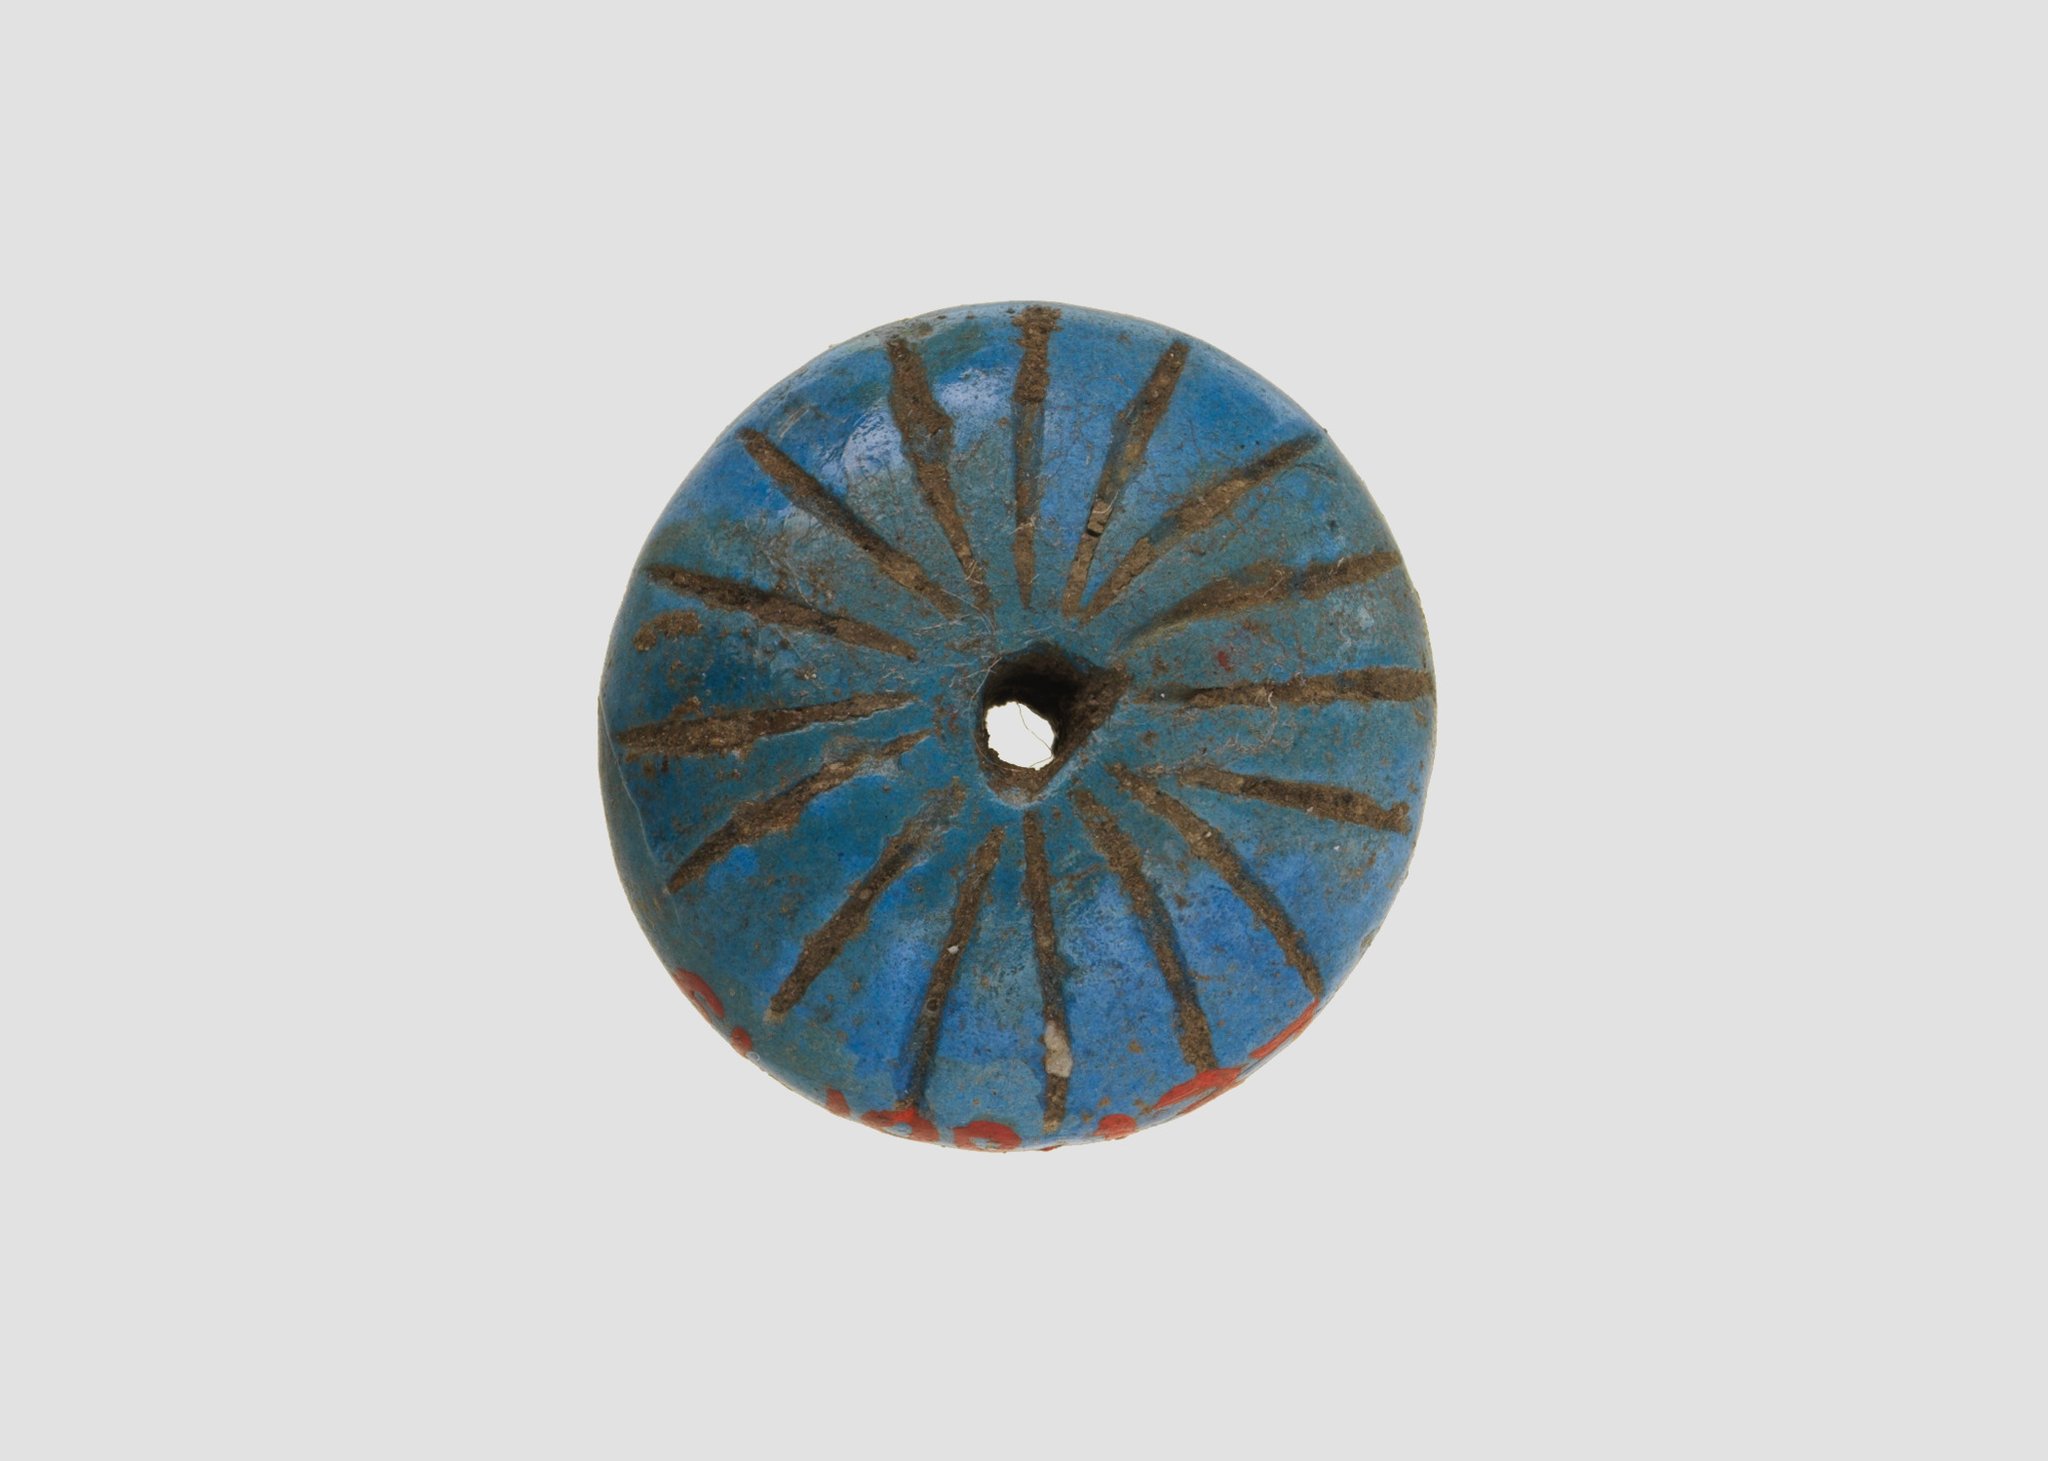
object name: bead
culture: iranian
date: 900-801 BCE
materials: glass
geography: iran